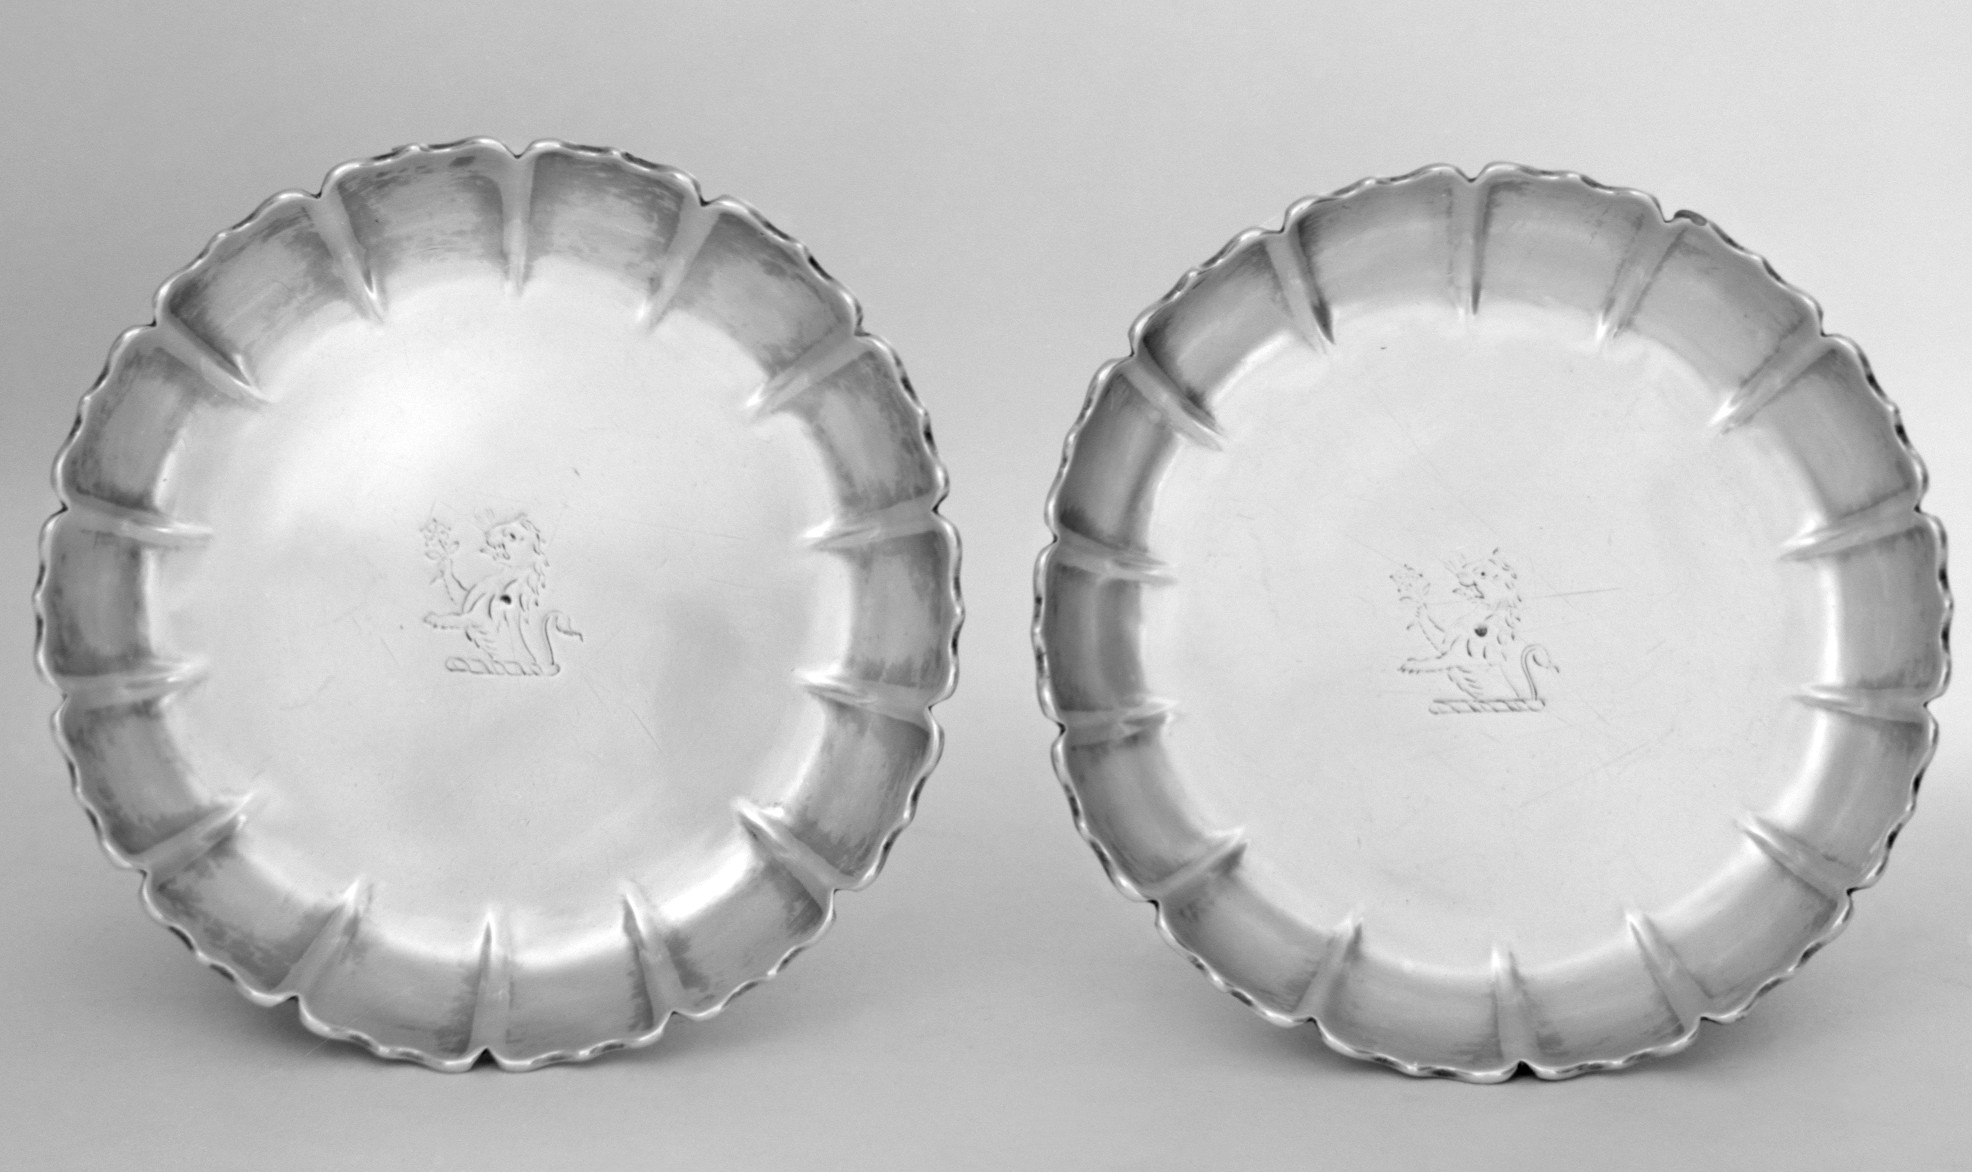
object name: dish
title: Pair of dishes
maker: edward workman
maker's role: maker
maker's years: 1619-1719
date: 1714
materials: silver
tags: lions